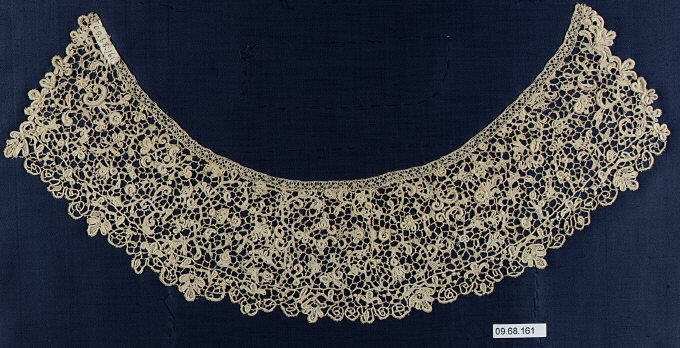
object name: collar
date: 1667-1700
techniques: lace